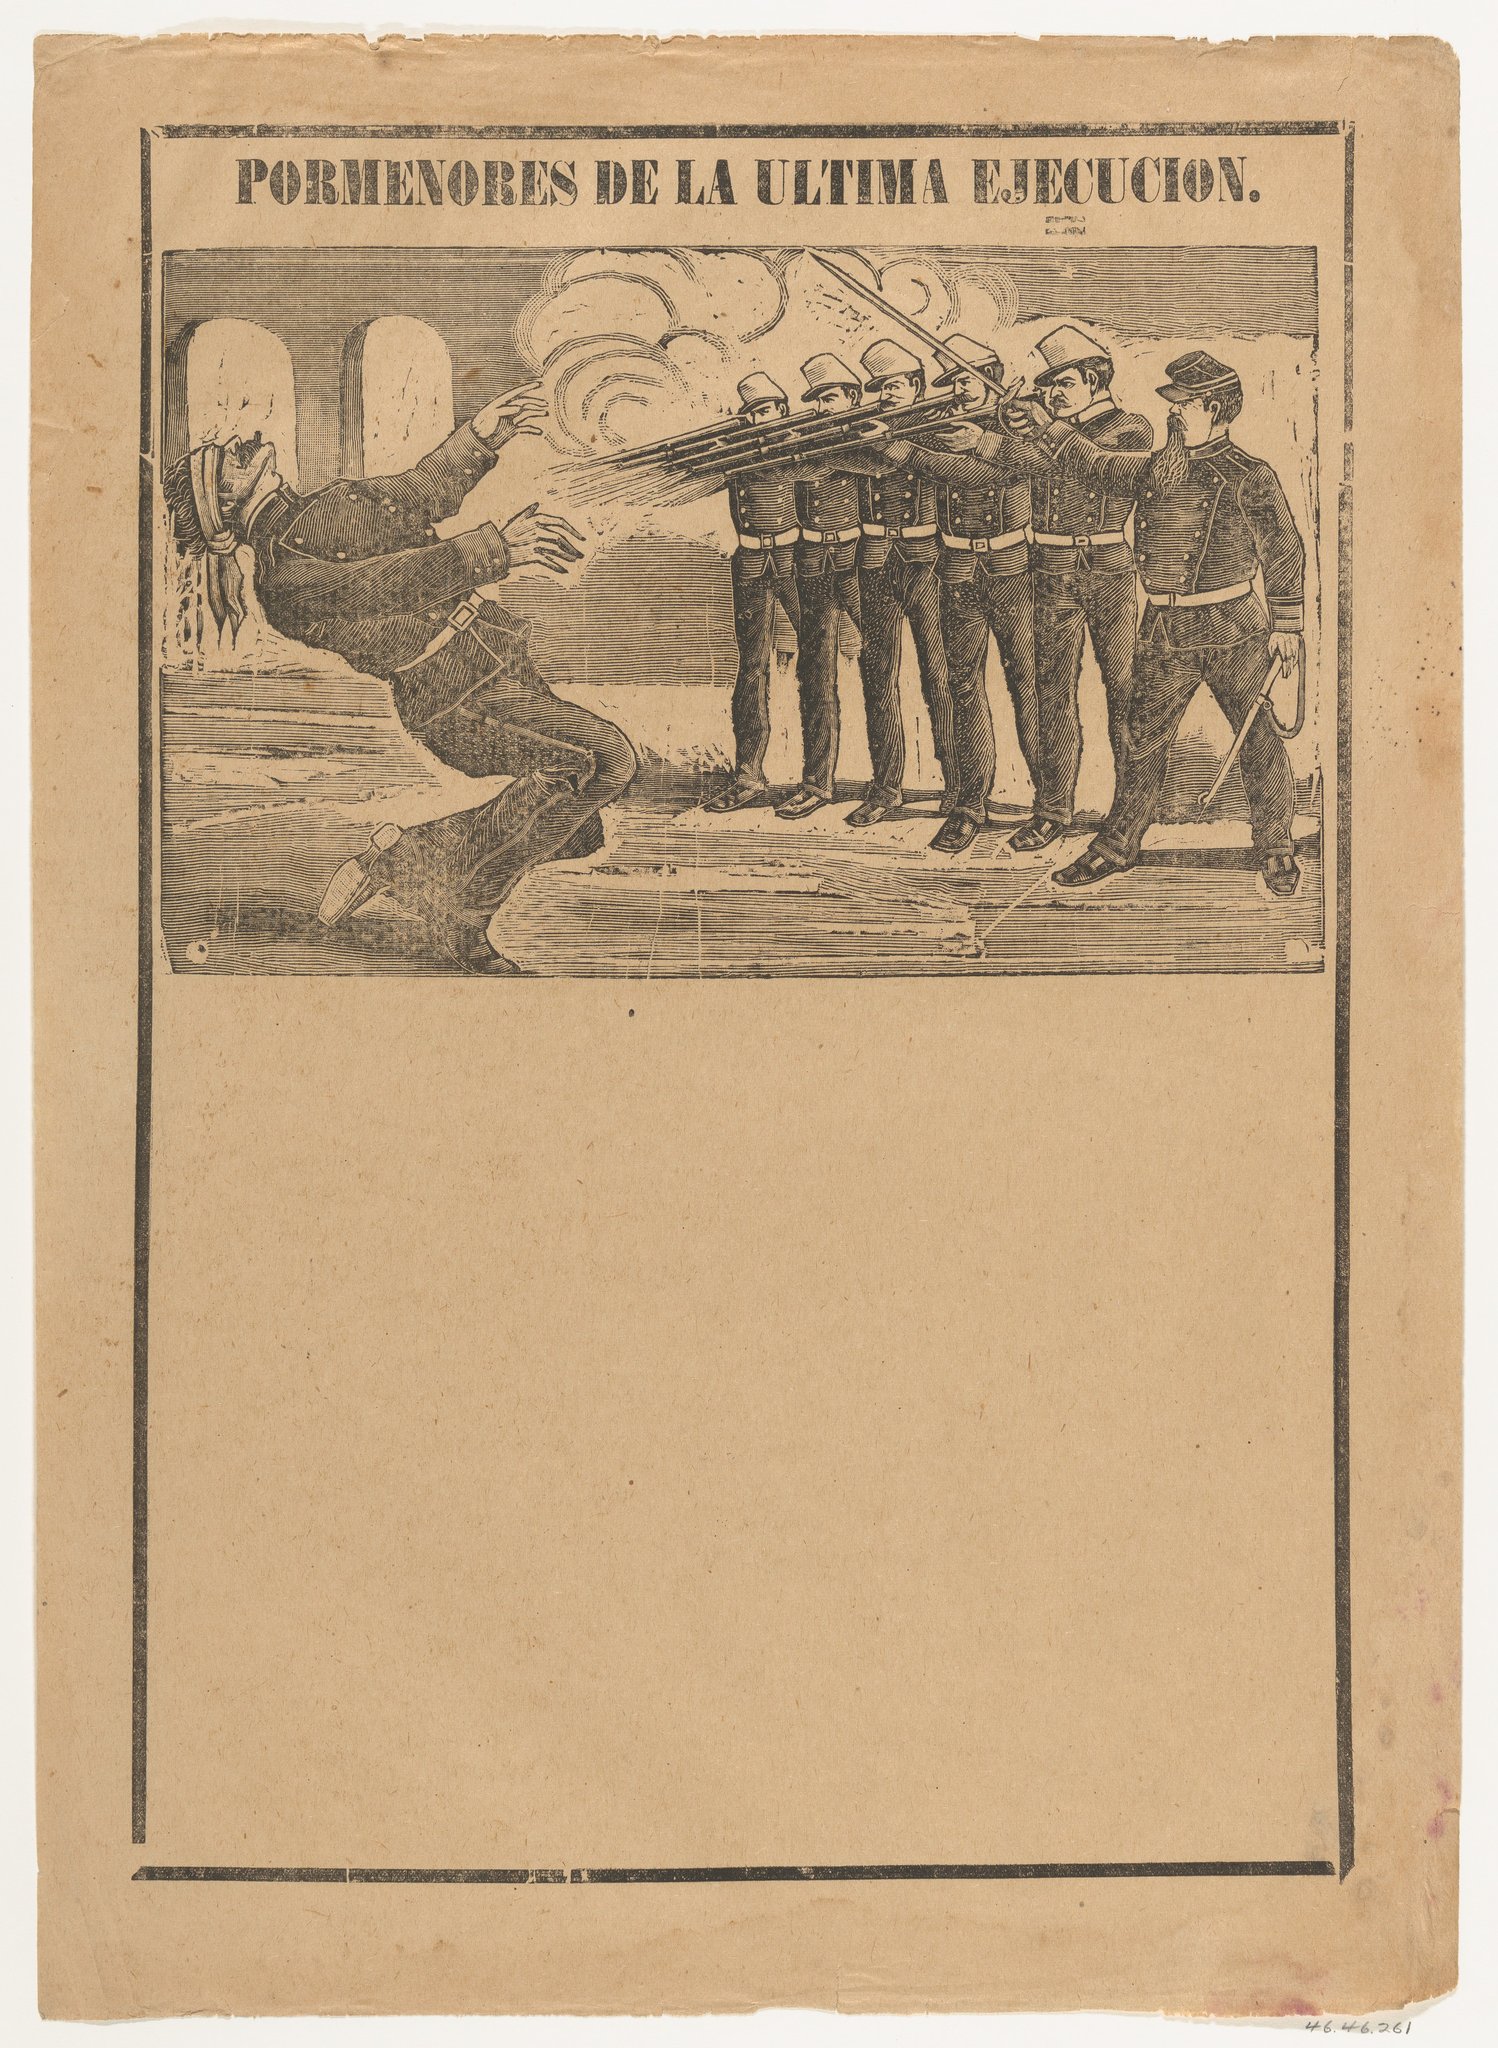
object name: print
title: Broadsheet showing a blindfolded man being executed (no letterpress in bottom section)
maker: josé guadalupe posada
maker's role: artist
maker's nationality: mexican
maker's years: 1852-1913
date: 1890-1910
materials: metal, paper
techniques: engraving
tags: soldiers,men,execution